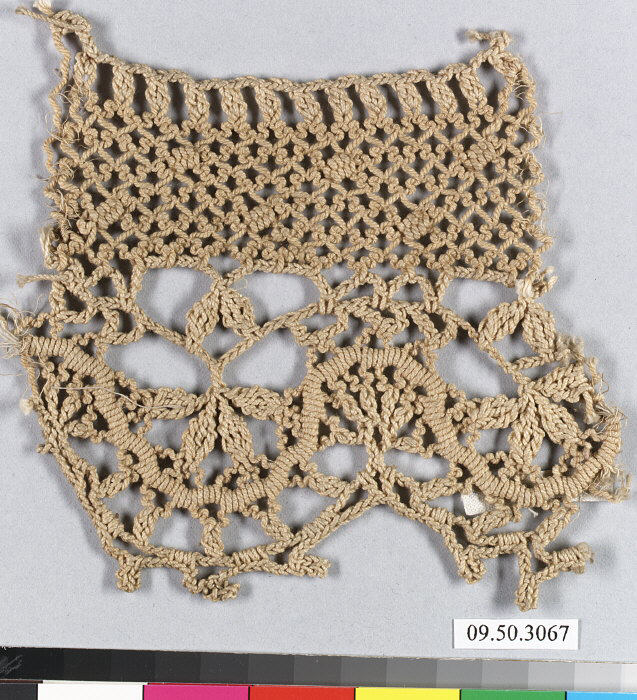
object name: sample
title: Crochet Work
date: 1801-1900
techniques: crochet